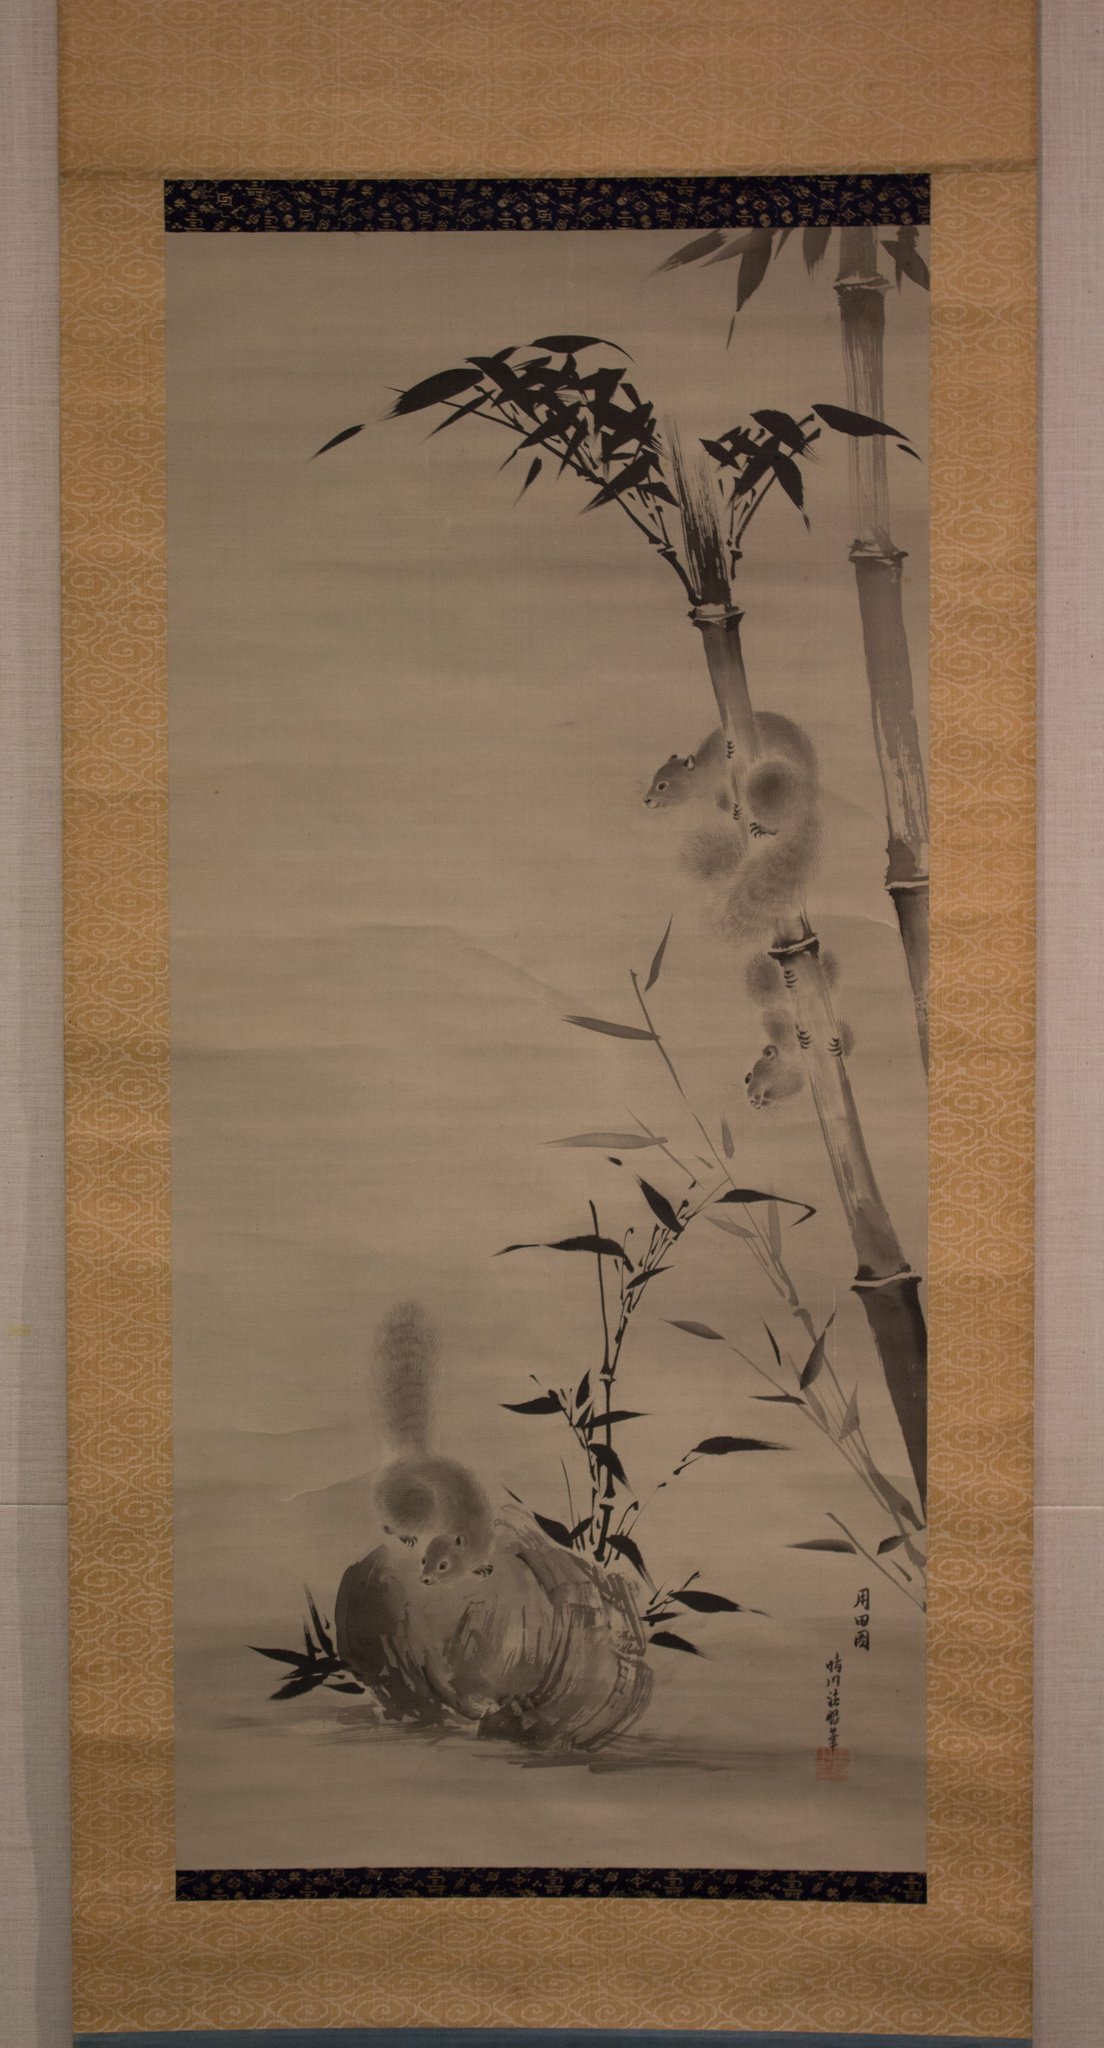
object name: hanging scroll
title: Squirrels on Bamboo and Rock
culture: japanese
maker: kano osanobu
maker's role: artist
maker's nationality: japanese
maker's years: 1796-1846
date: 1820-1829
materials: ink, silk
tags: squirrels,bamboo